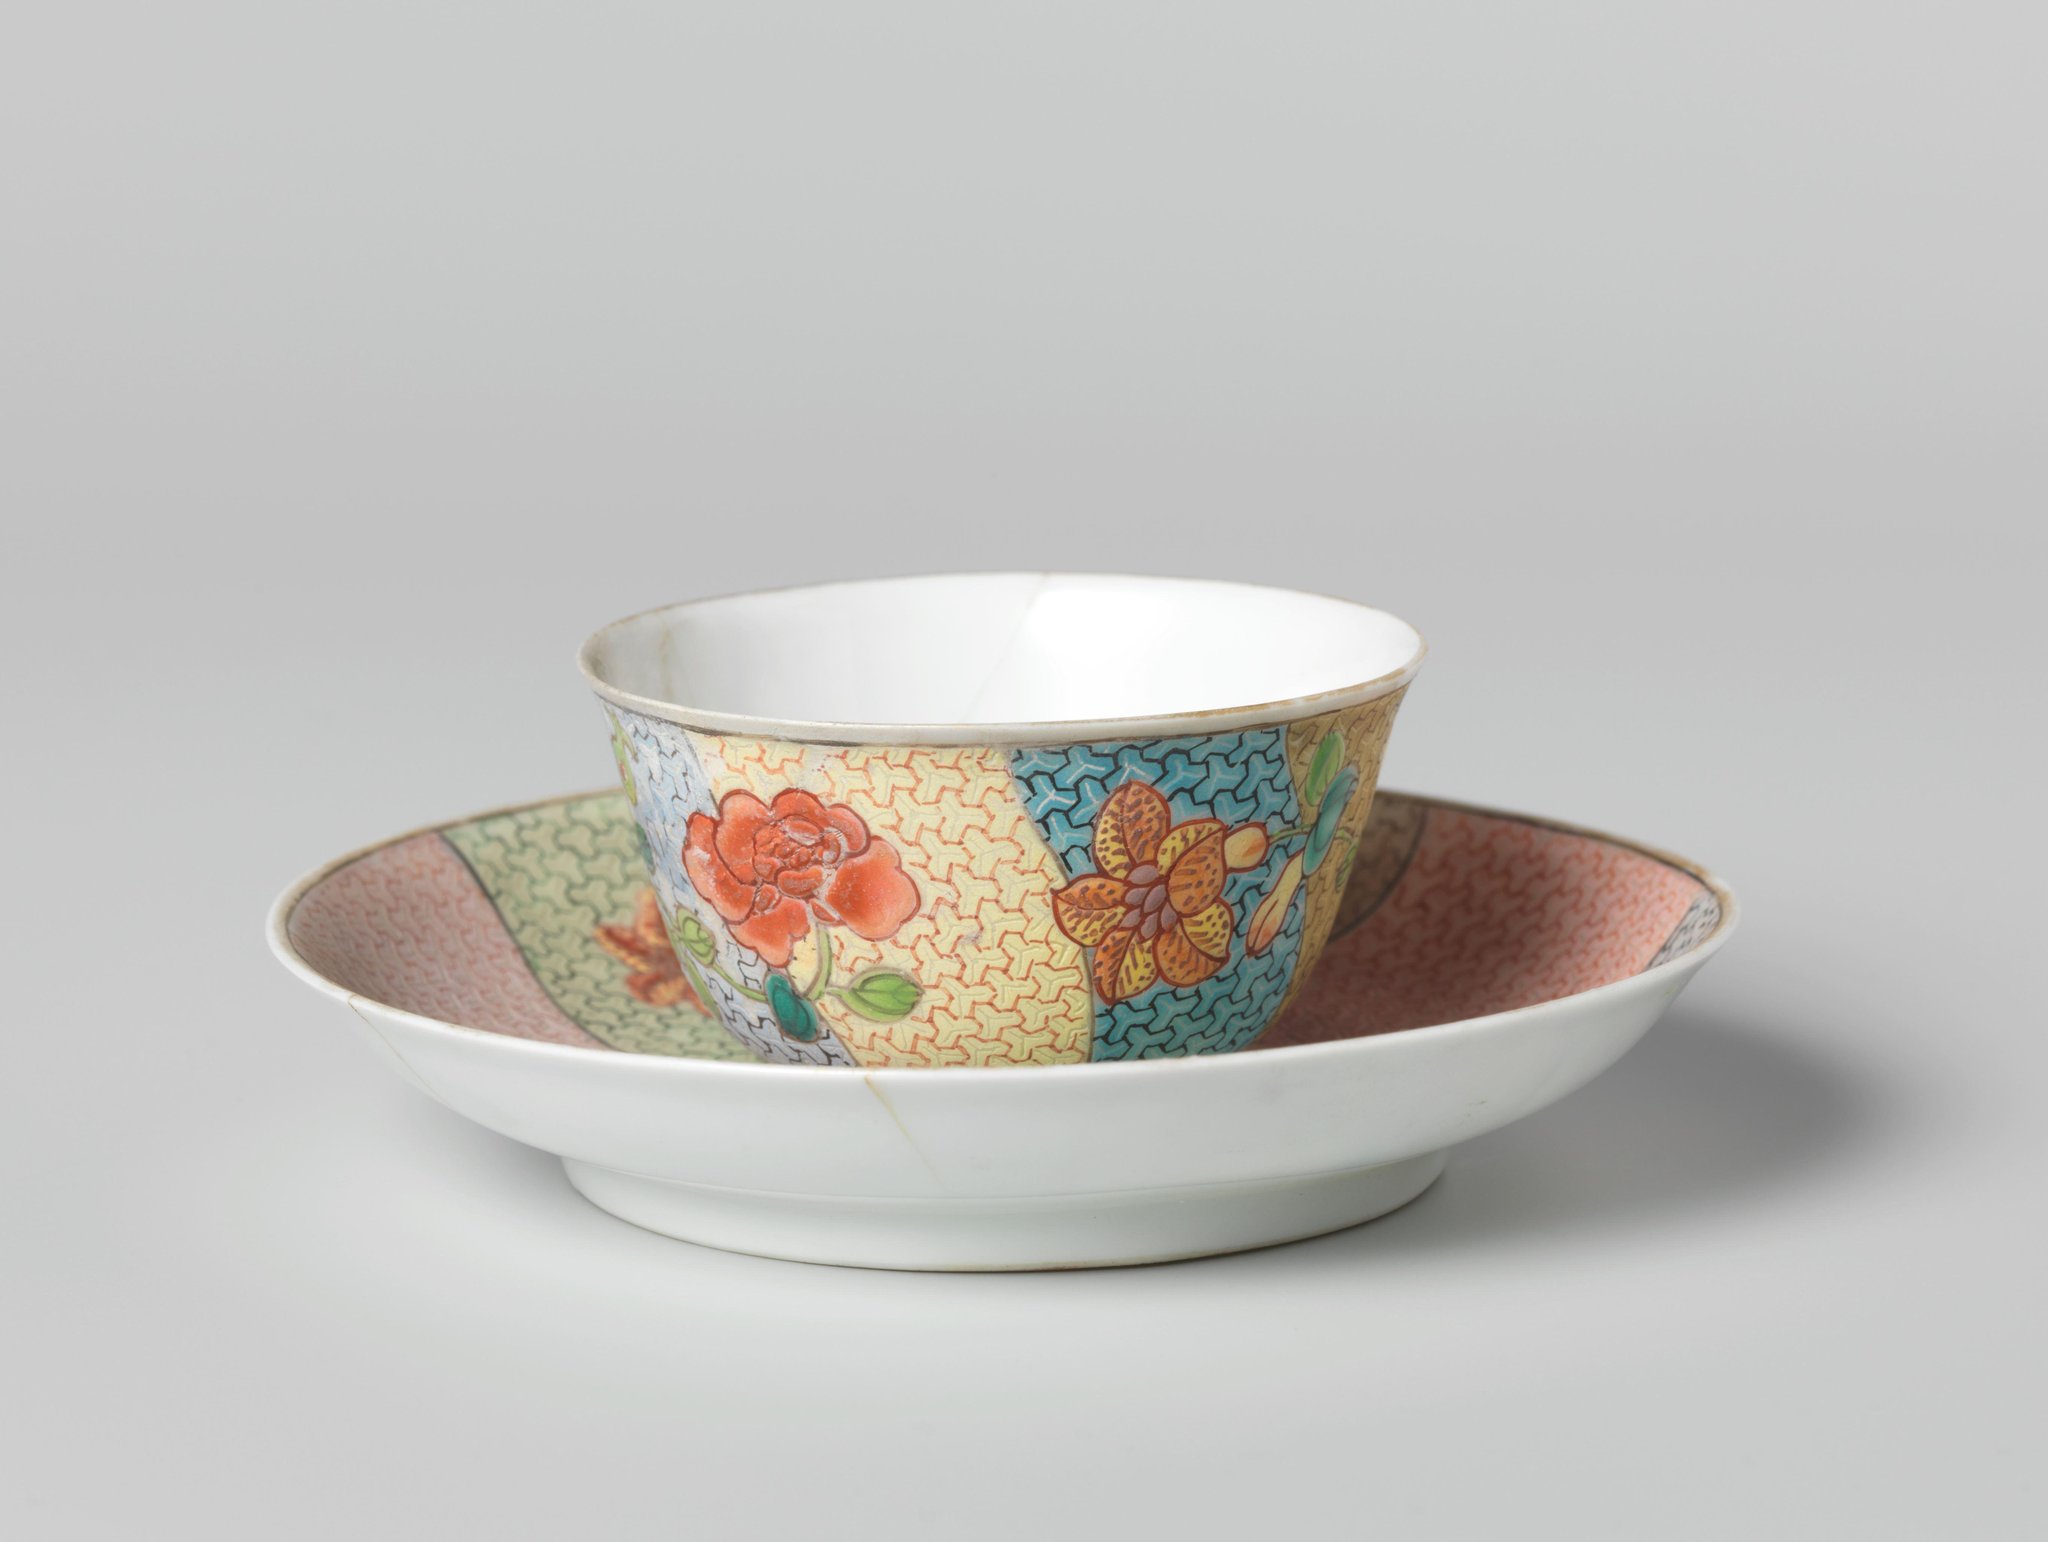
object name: kop en schotel, kop en schotel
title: Bell-shaped cup and saucer with three flower sprays on multi-colored diaper-pattern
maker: Anonymous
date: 1725-1749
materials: glaze, gold, paint, porcelain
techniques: firing, gilding, turning, vitrification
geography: china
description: Klokvormige kop en schotel van porselein, beschilderd op het glazuur in blauw, rood, roze, groen, geel, zwart en goud. Op het plat van de schotel in een medaillon een gestileerde lotusbloem; vanuit dit medaillon acht getordeerde vakken met verschillend gekleurd servetwerk, op deze vakken drie bloemtakken (pioen, magnolia). Kop met dezelfde decoratie. Zowel schotel als kop gebroken geweest. Porselein met emailkleuren.